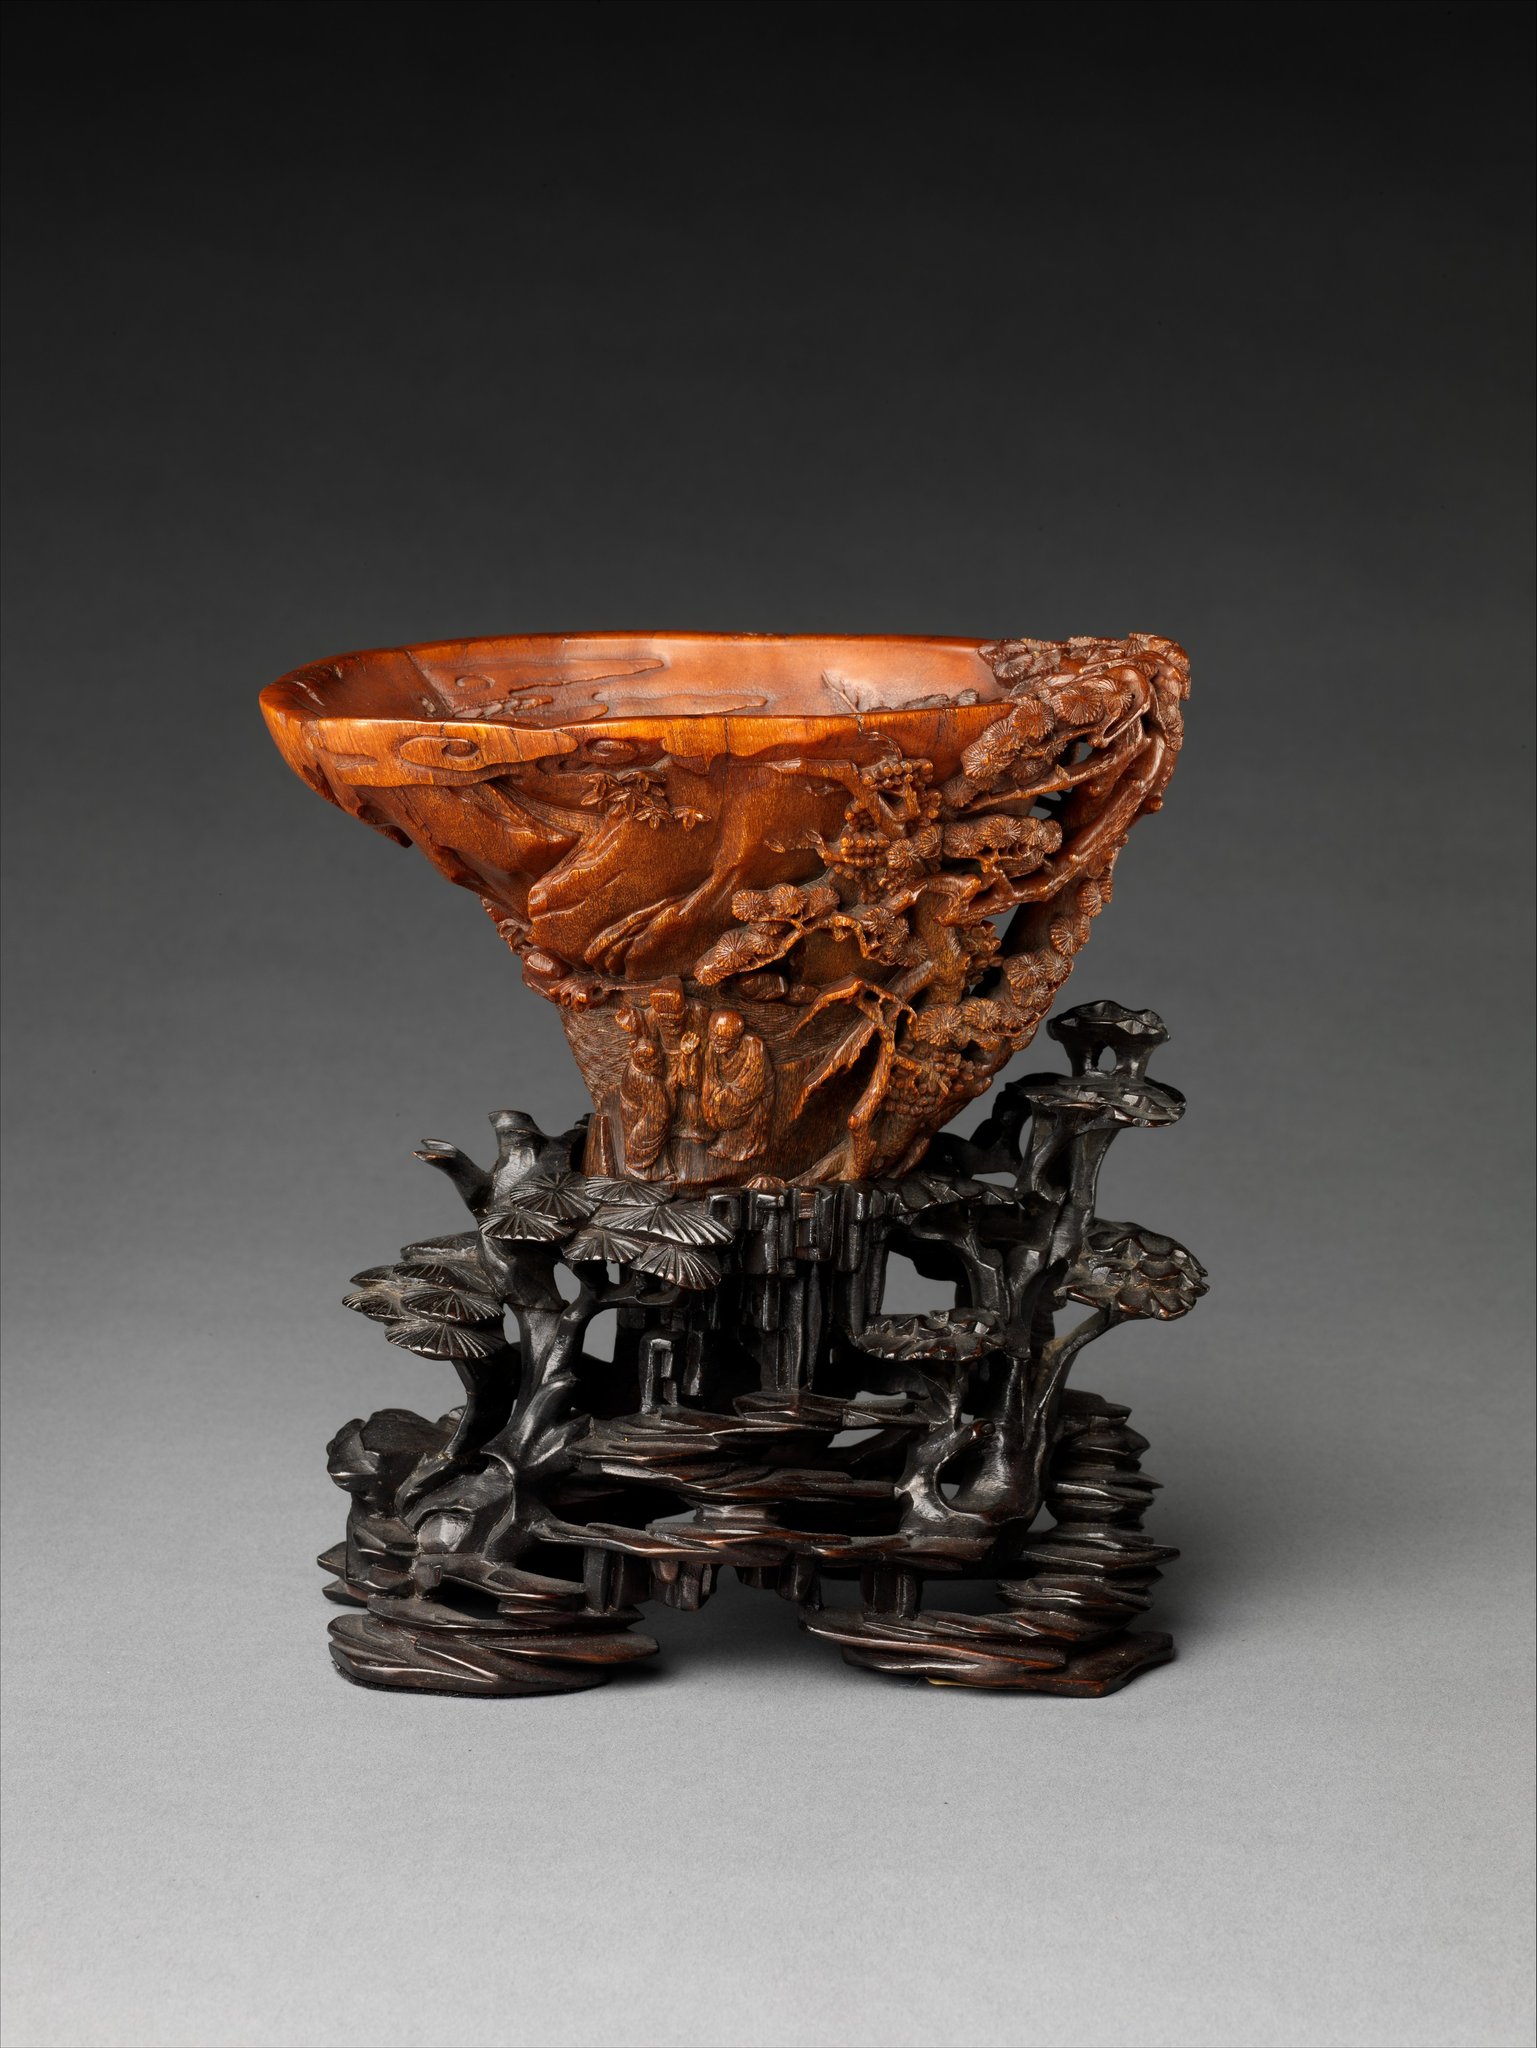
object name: cup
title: Cup depicting Three Laughers of Tiger Ravine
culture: chinese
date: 1701-1800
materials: horn